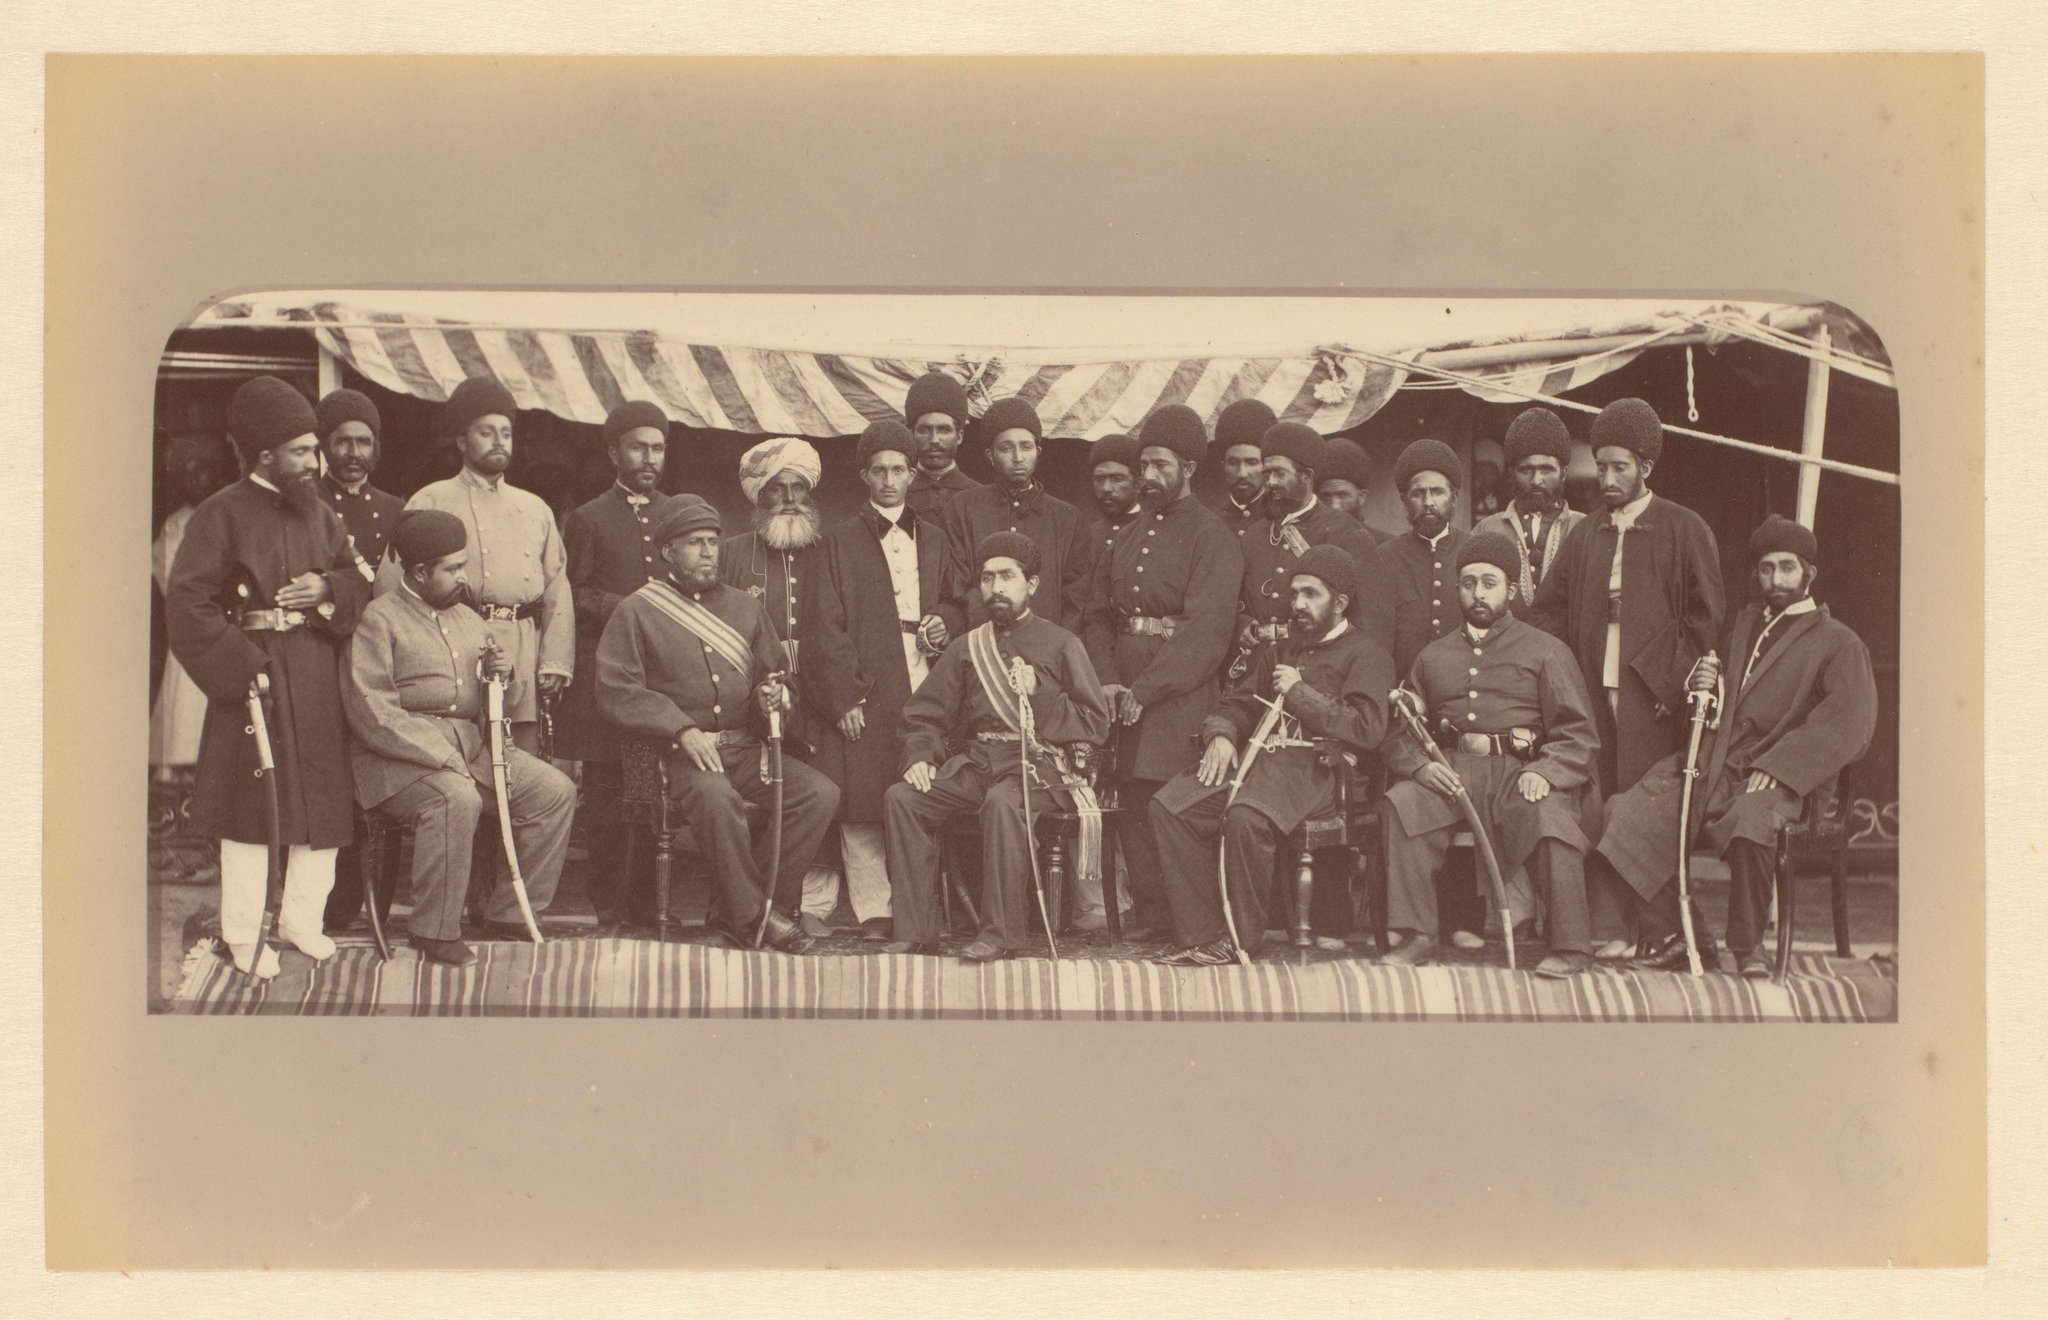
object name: photograph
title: Group portrait of Mohammed Jakub Khan surrounded by his officials including Daoud Shah and Habibullah Mustafi, Afghanistan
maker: j.n.o. burke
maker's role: fotograaf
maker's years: 1843-1900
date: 1805-1879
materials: paper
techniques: albumen print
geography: afghanistan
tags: historical persons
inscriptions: number: ‘160’